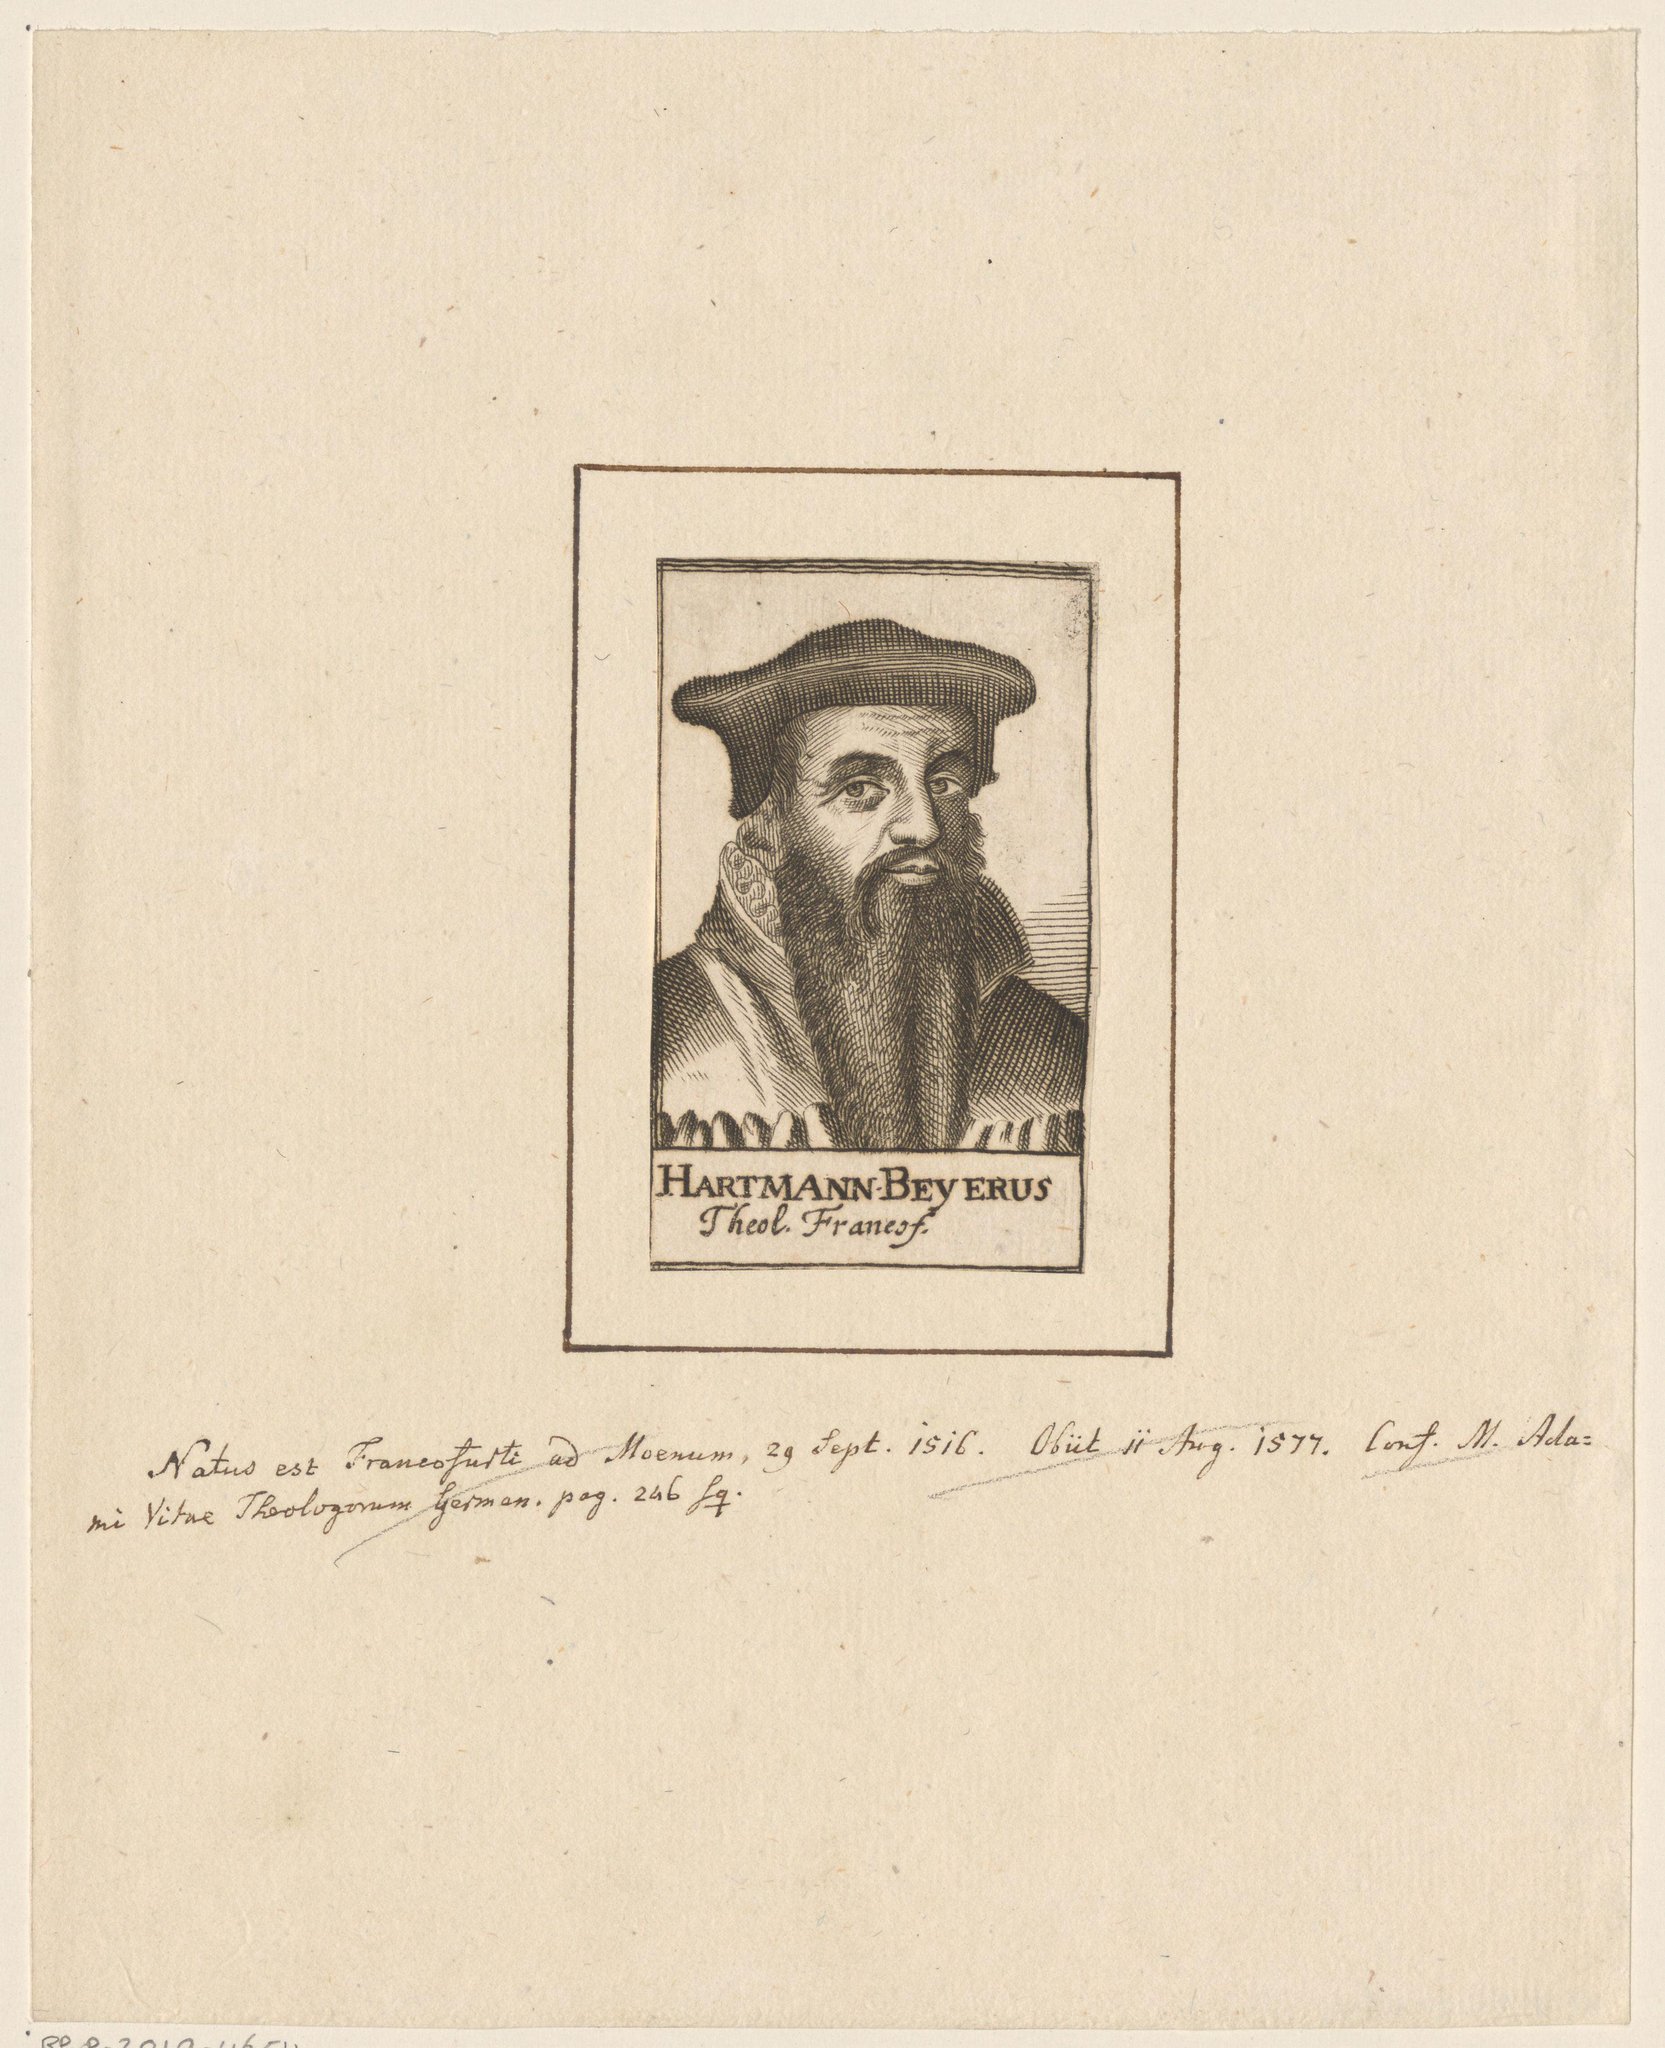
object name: print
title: Portret van Hartmann Beyer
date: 1688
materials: paper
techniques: engraving, etching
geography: nuremberg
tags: theologian, historical persons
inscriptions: inscription: ‘Natus est Francofurti ad Moenum 29 Sept 1516 [...]’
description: Prent uit: Freher, Paul. Theatrum virorum eruditione clarorum. Neurenberg: Johann Hoffmann, 1688.